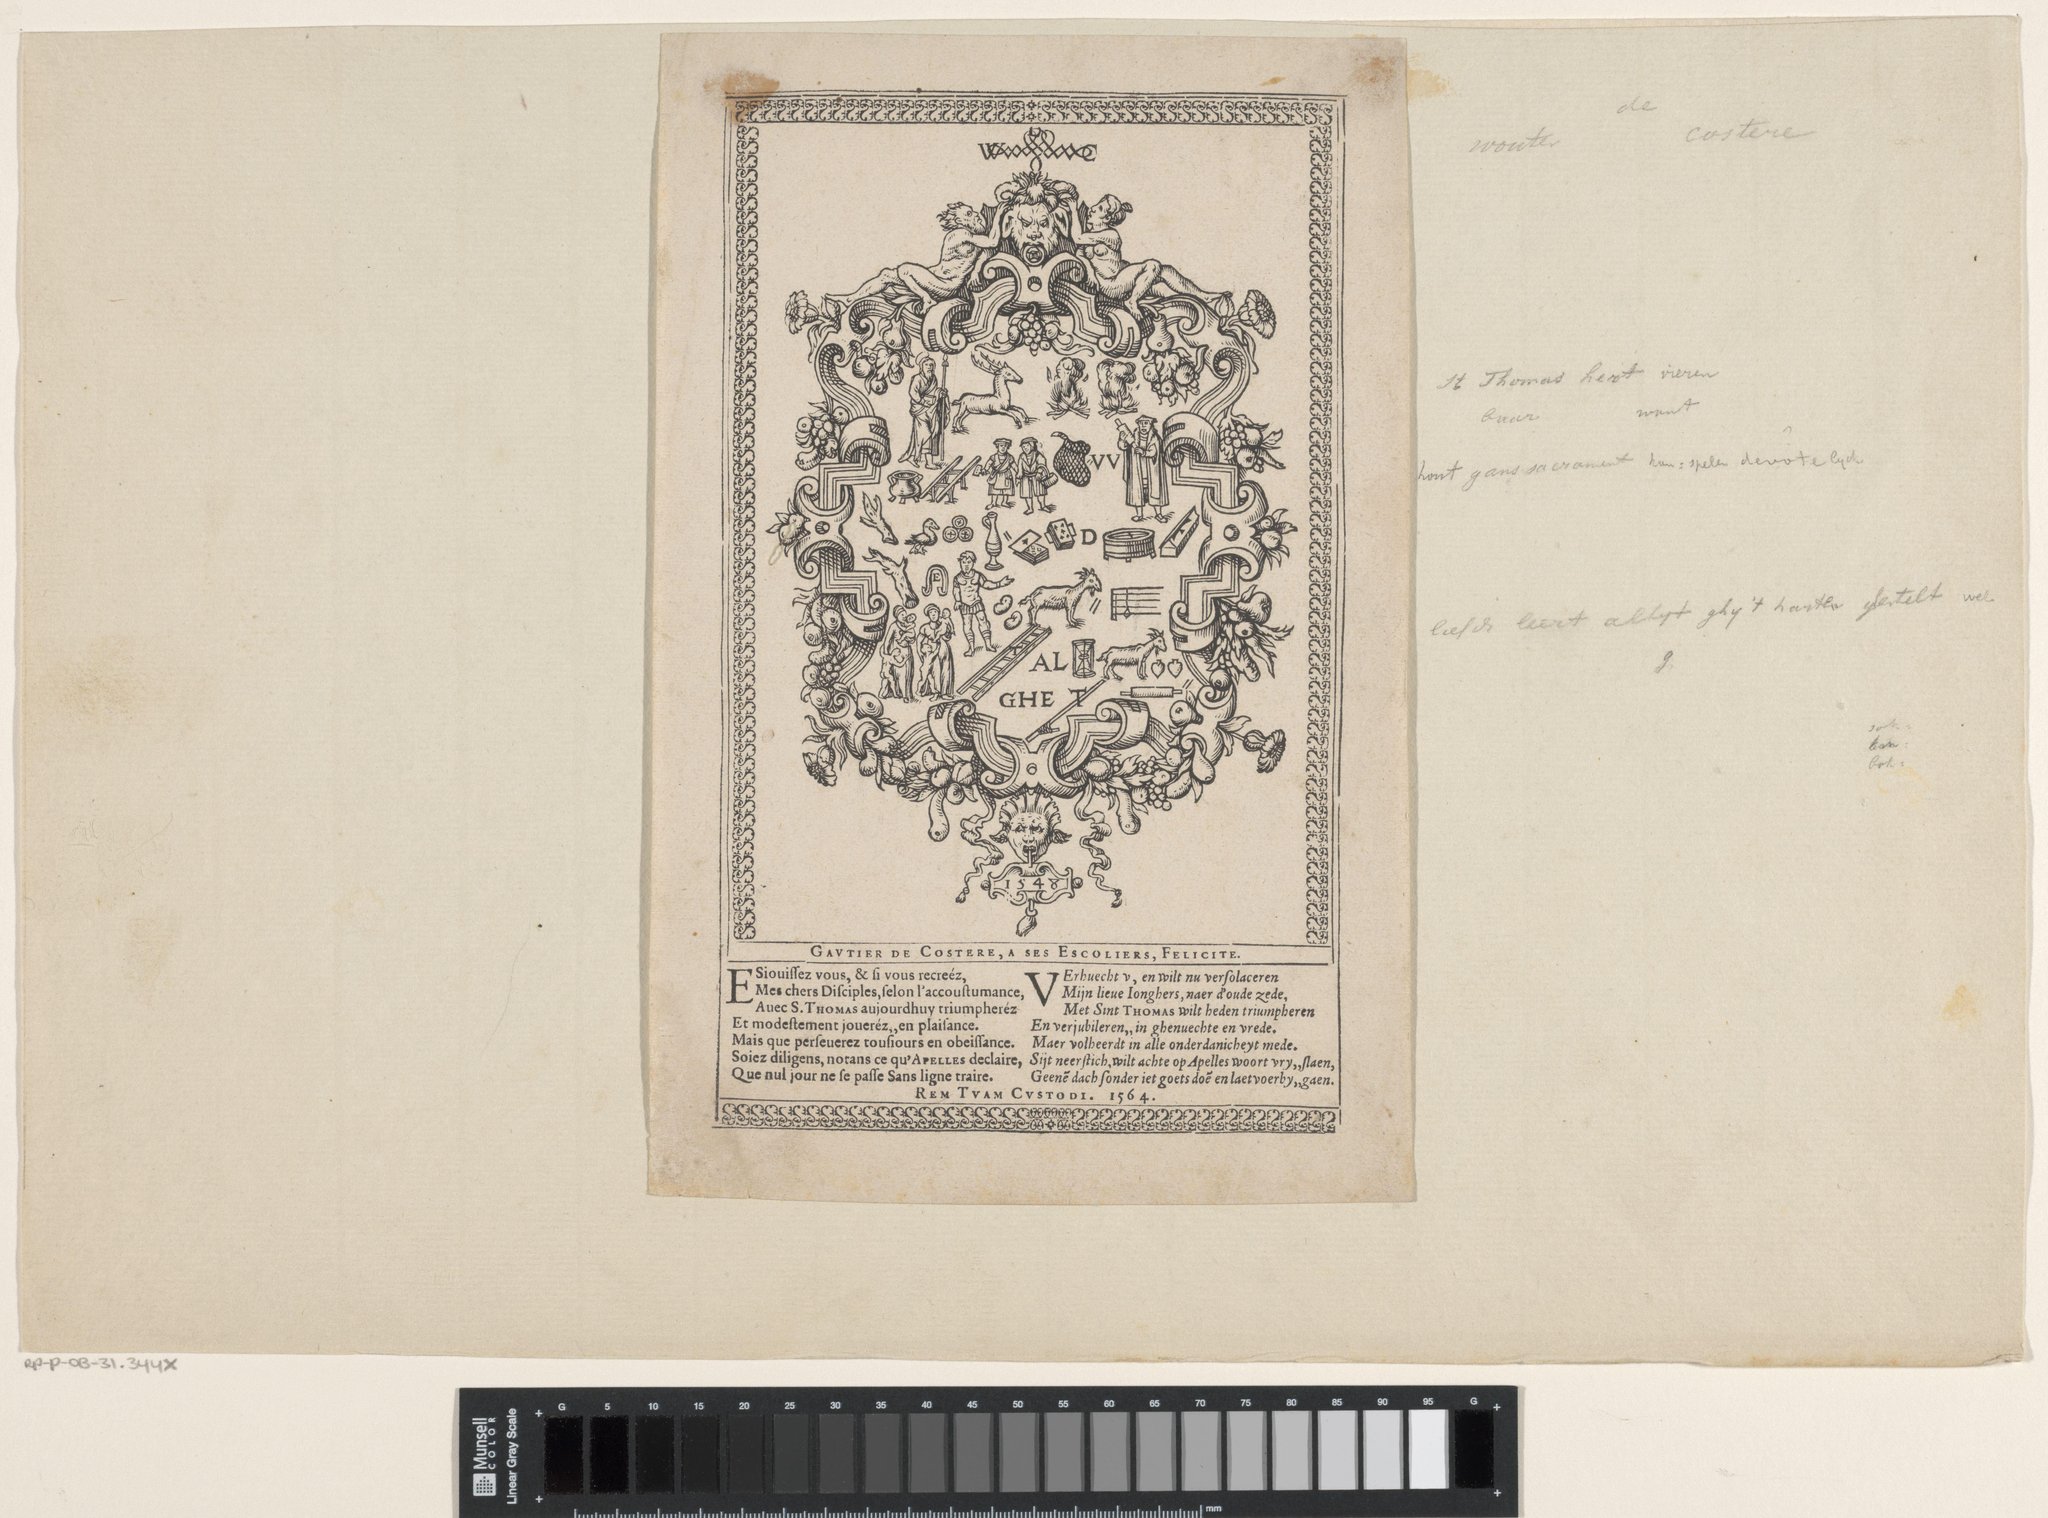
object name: print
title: Rebus met tientallen voorstellingen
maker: Anonymous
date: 1564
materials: paper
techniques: letterpress printing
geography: netherlands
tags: rebus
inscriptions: collector's mark: Lugt 240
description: Rebus met tientallen voorstellingen in een geornamenteerd ovaal van arabesken, vruchten en bloemen. In een kader twee kolommen met zeven regels Franse en zeven regels Nederlandse tekst.